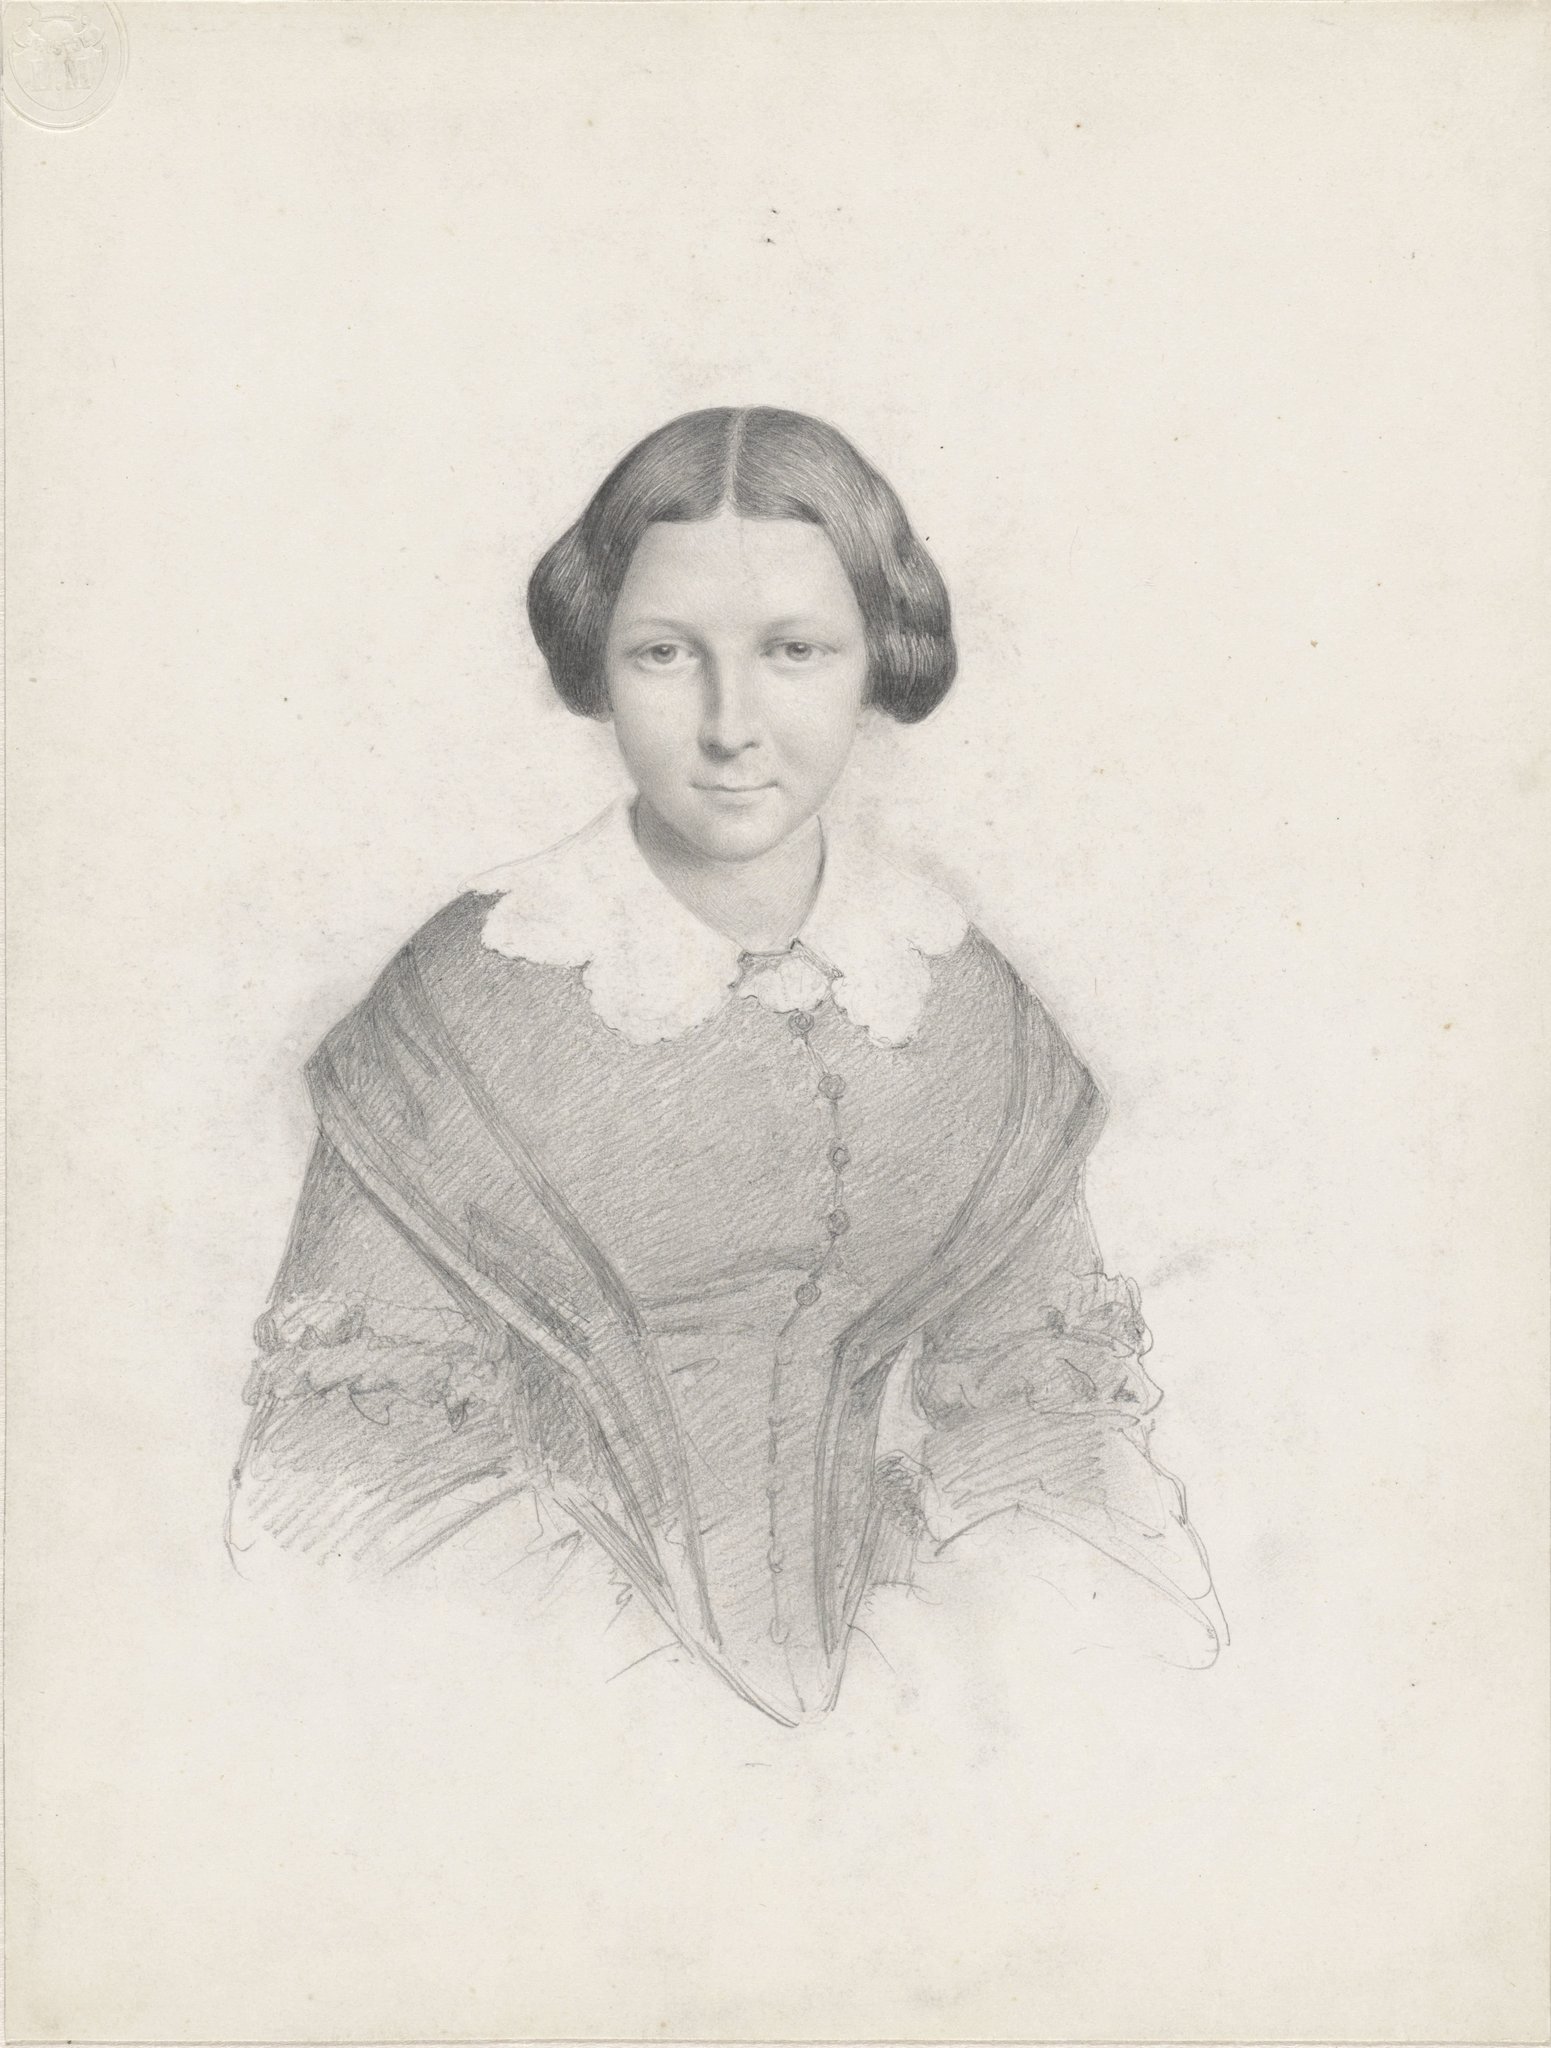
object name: drawing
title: Portret van een jonge vrouw, van voren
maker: jan cornelis van rossum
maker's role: draughtsman, painter, print maker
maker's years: 1820-1905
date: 1830-1903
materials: paper, pencil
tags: anonymous historical person portrayed alone